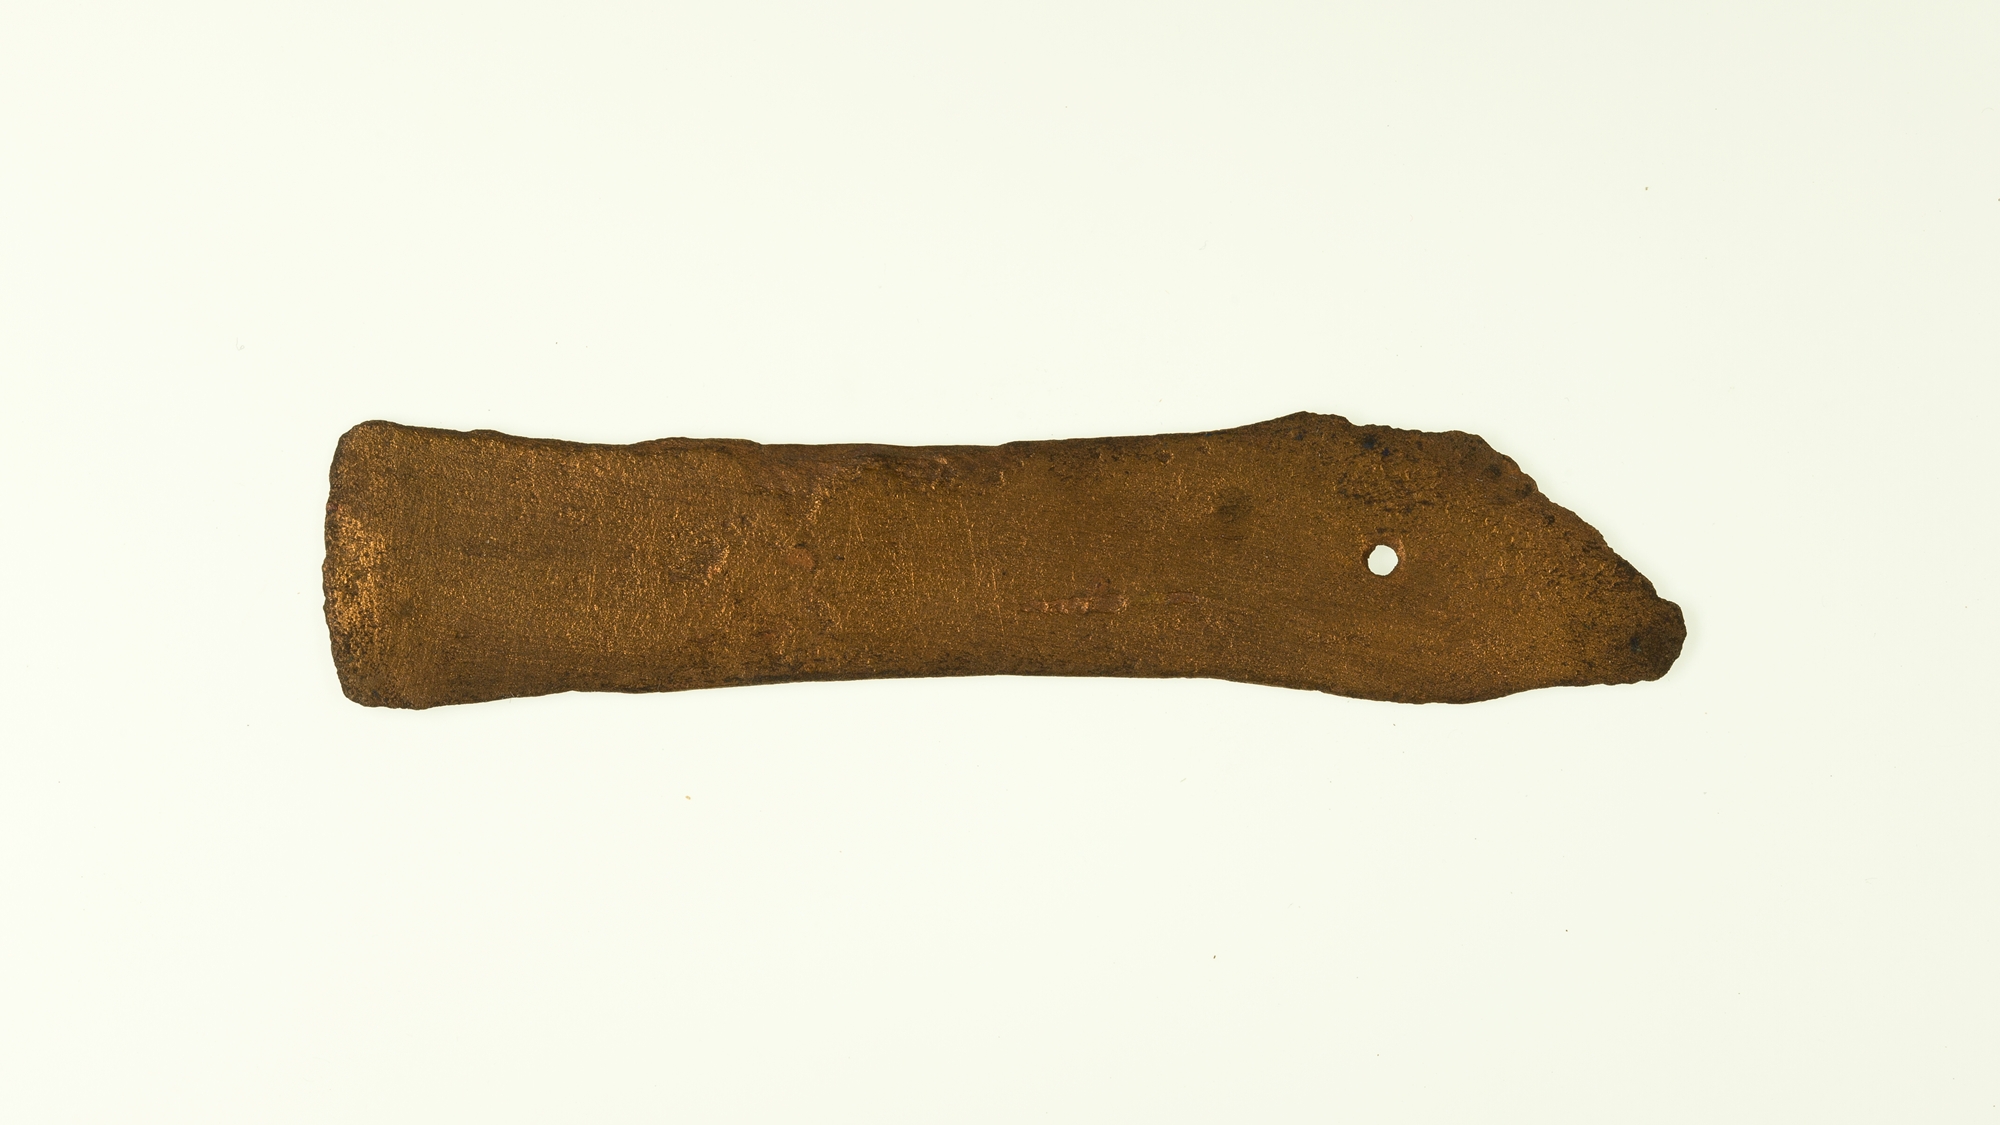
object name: knife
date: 1295-1070 BCE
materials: bronze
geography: egypt